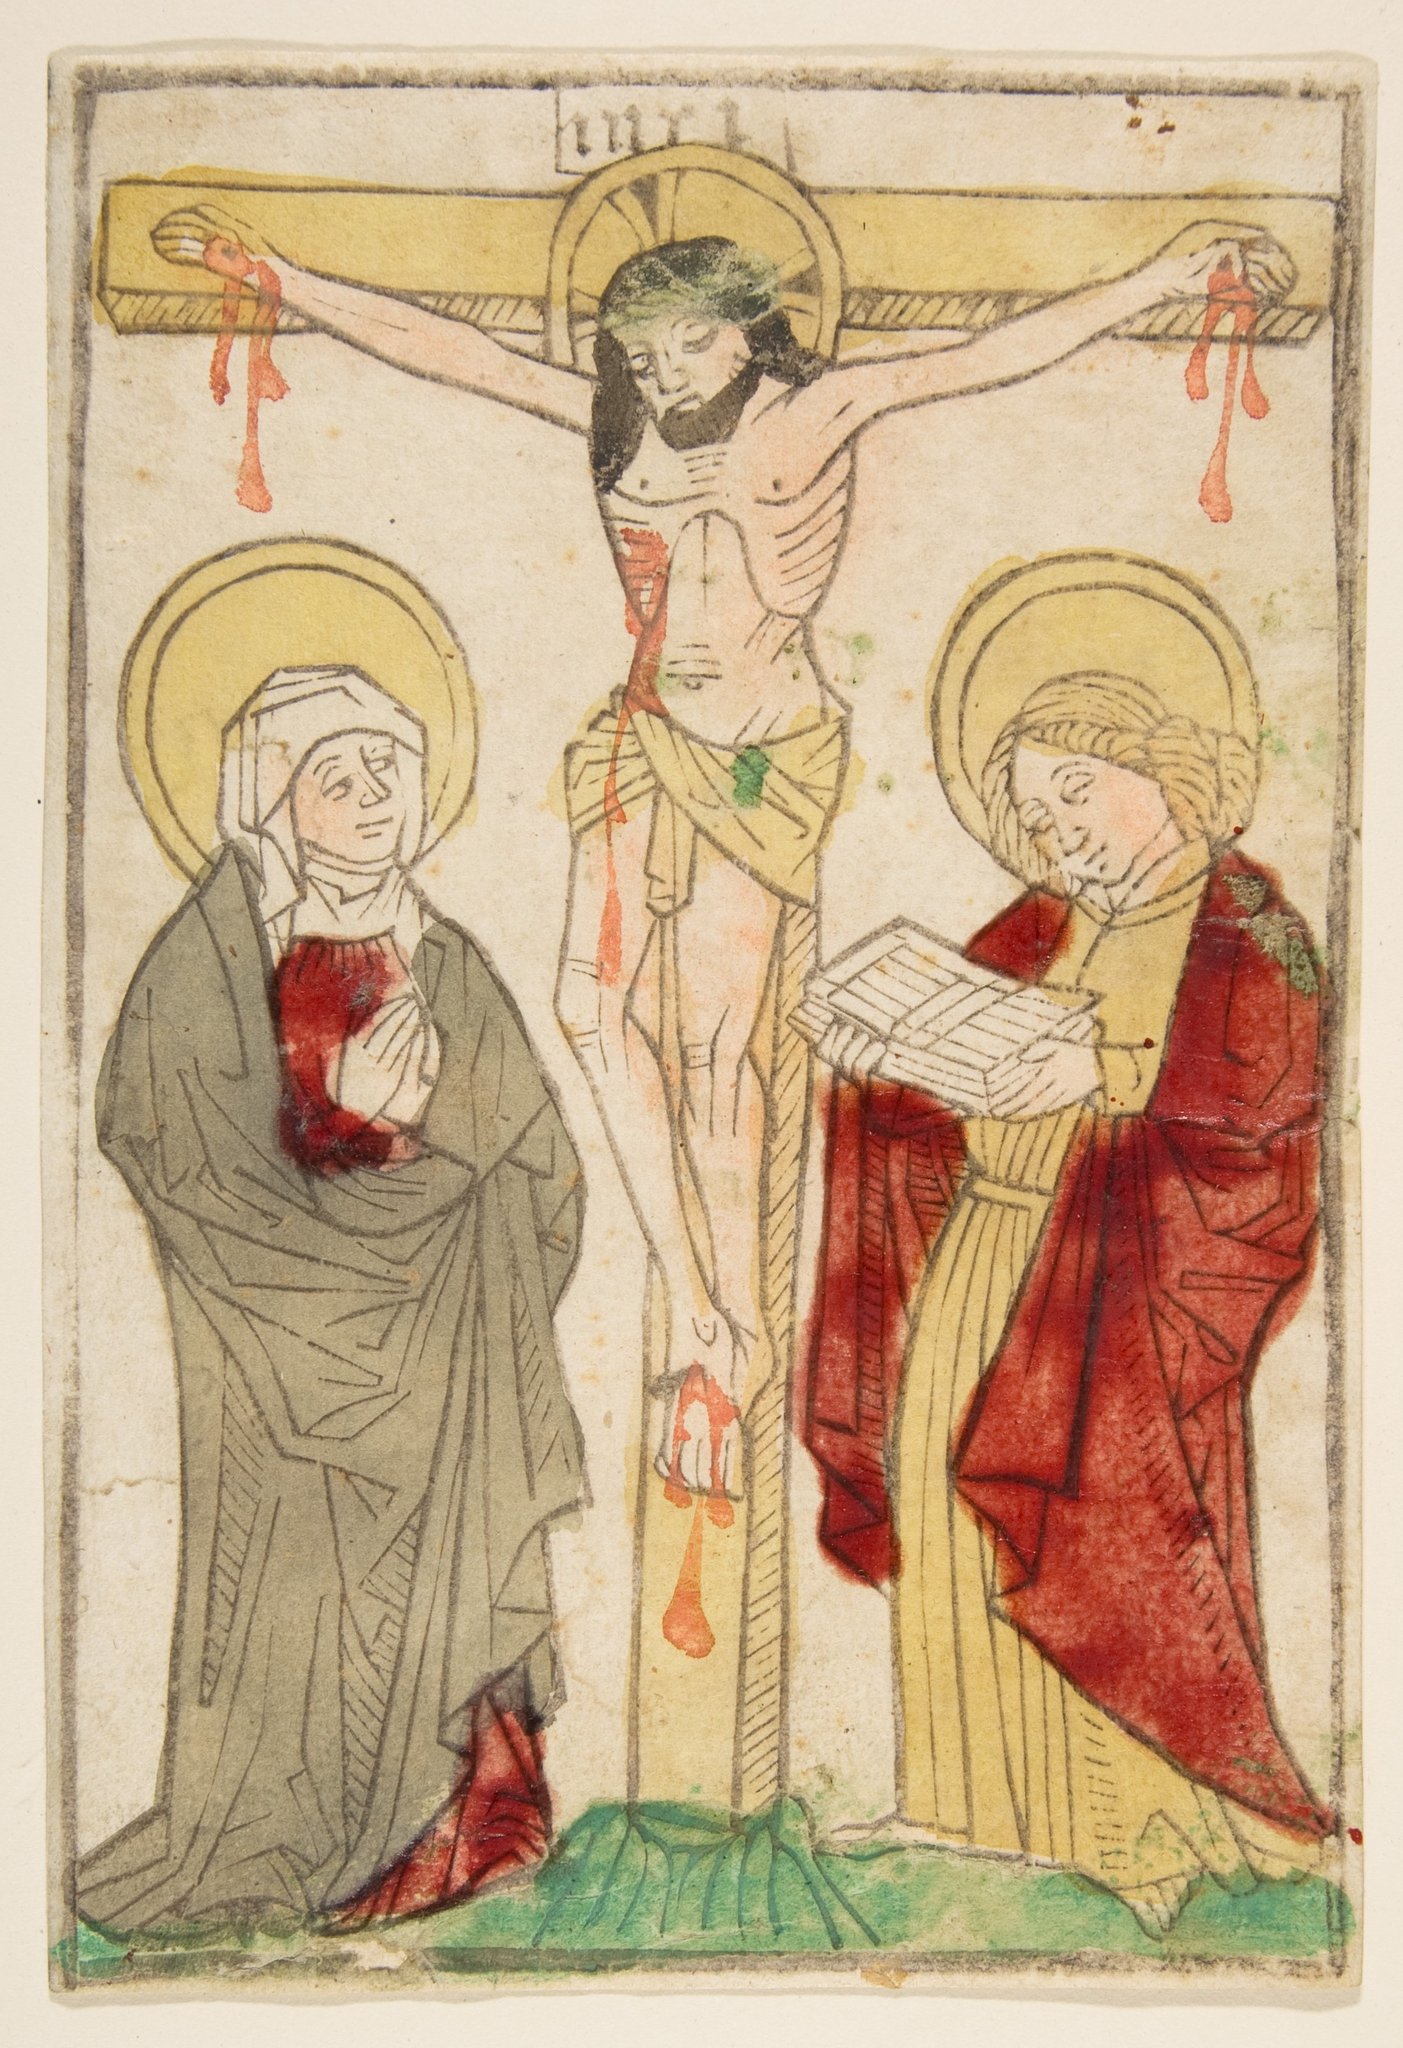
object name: print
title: Christ on the Cross with the Virgin and Saint John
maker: anonymous, german, swabia, 15th century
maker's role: artist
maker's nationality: german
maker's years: 1400-1500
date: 1480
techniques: hand coloring, woodcut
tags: christ,virgin mary,crucifixion,saints